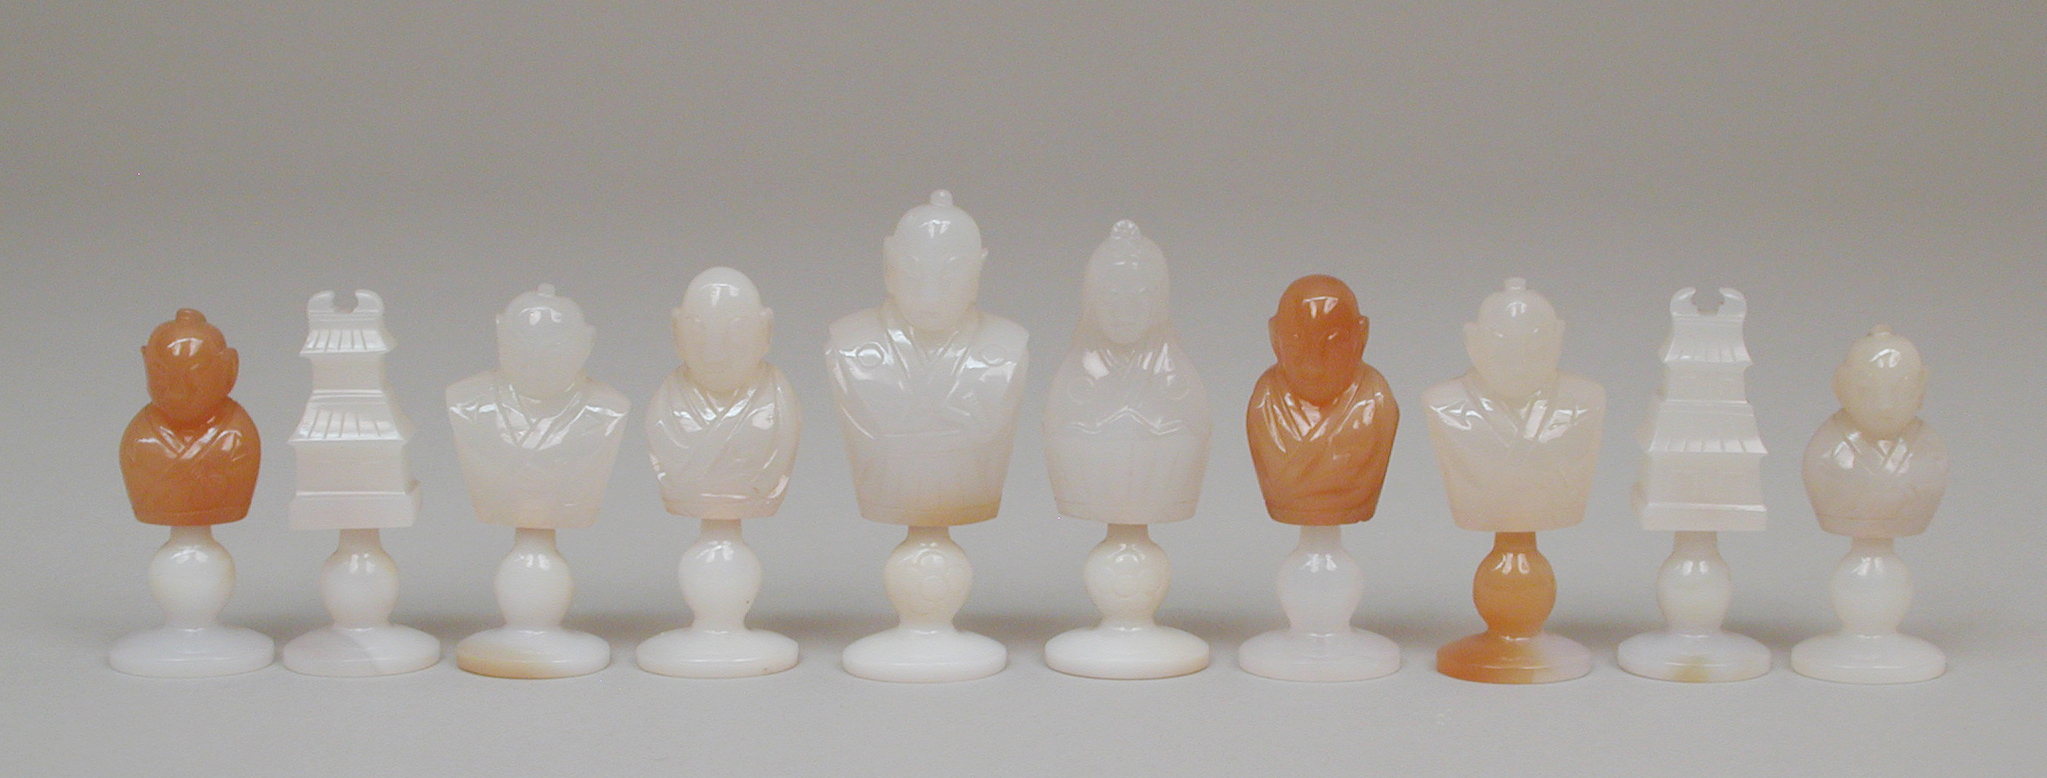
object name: chessman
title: Chessmen (32)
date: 1867-1900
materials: gemstone, stone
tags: chess